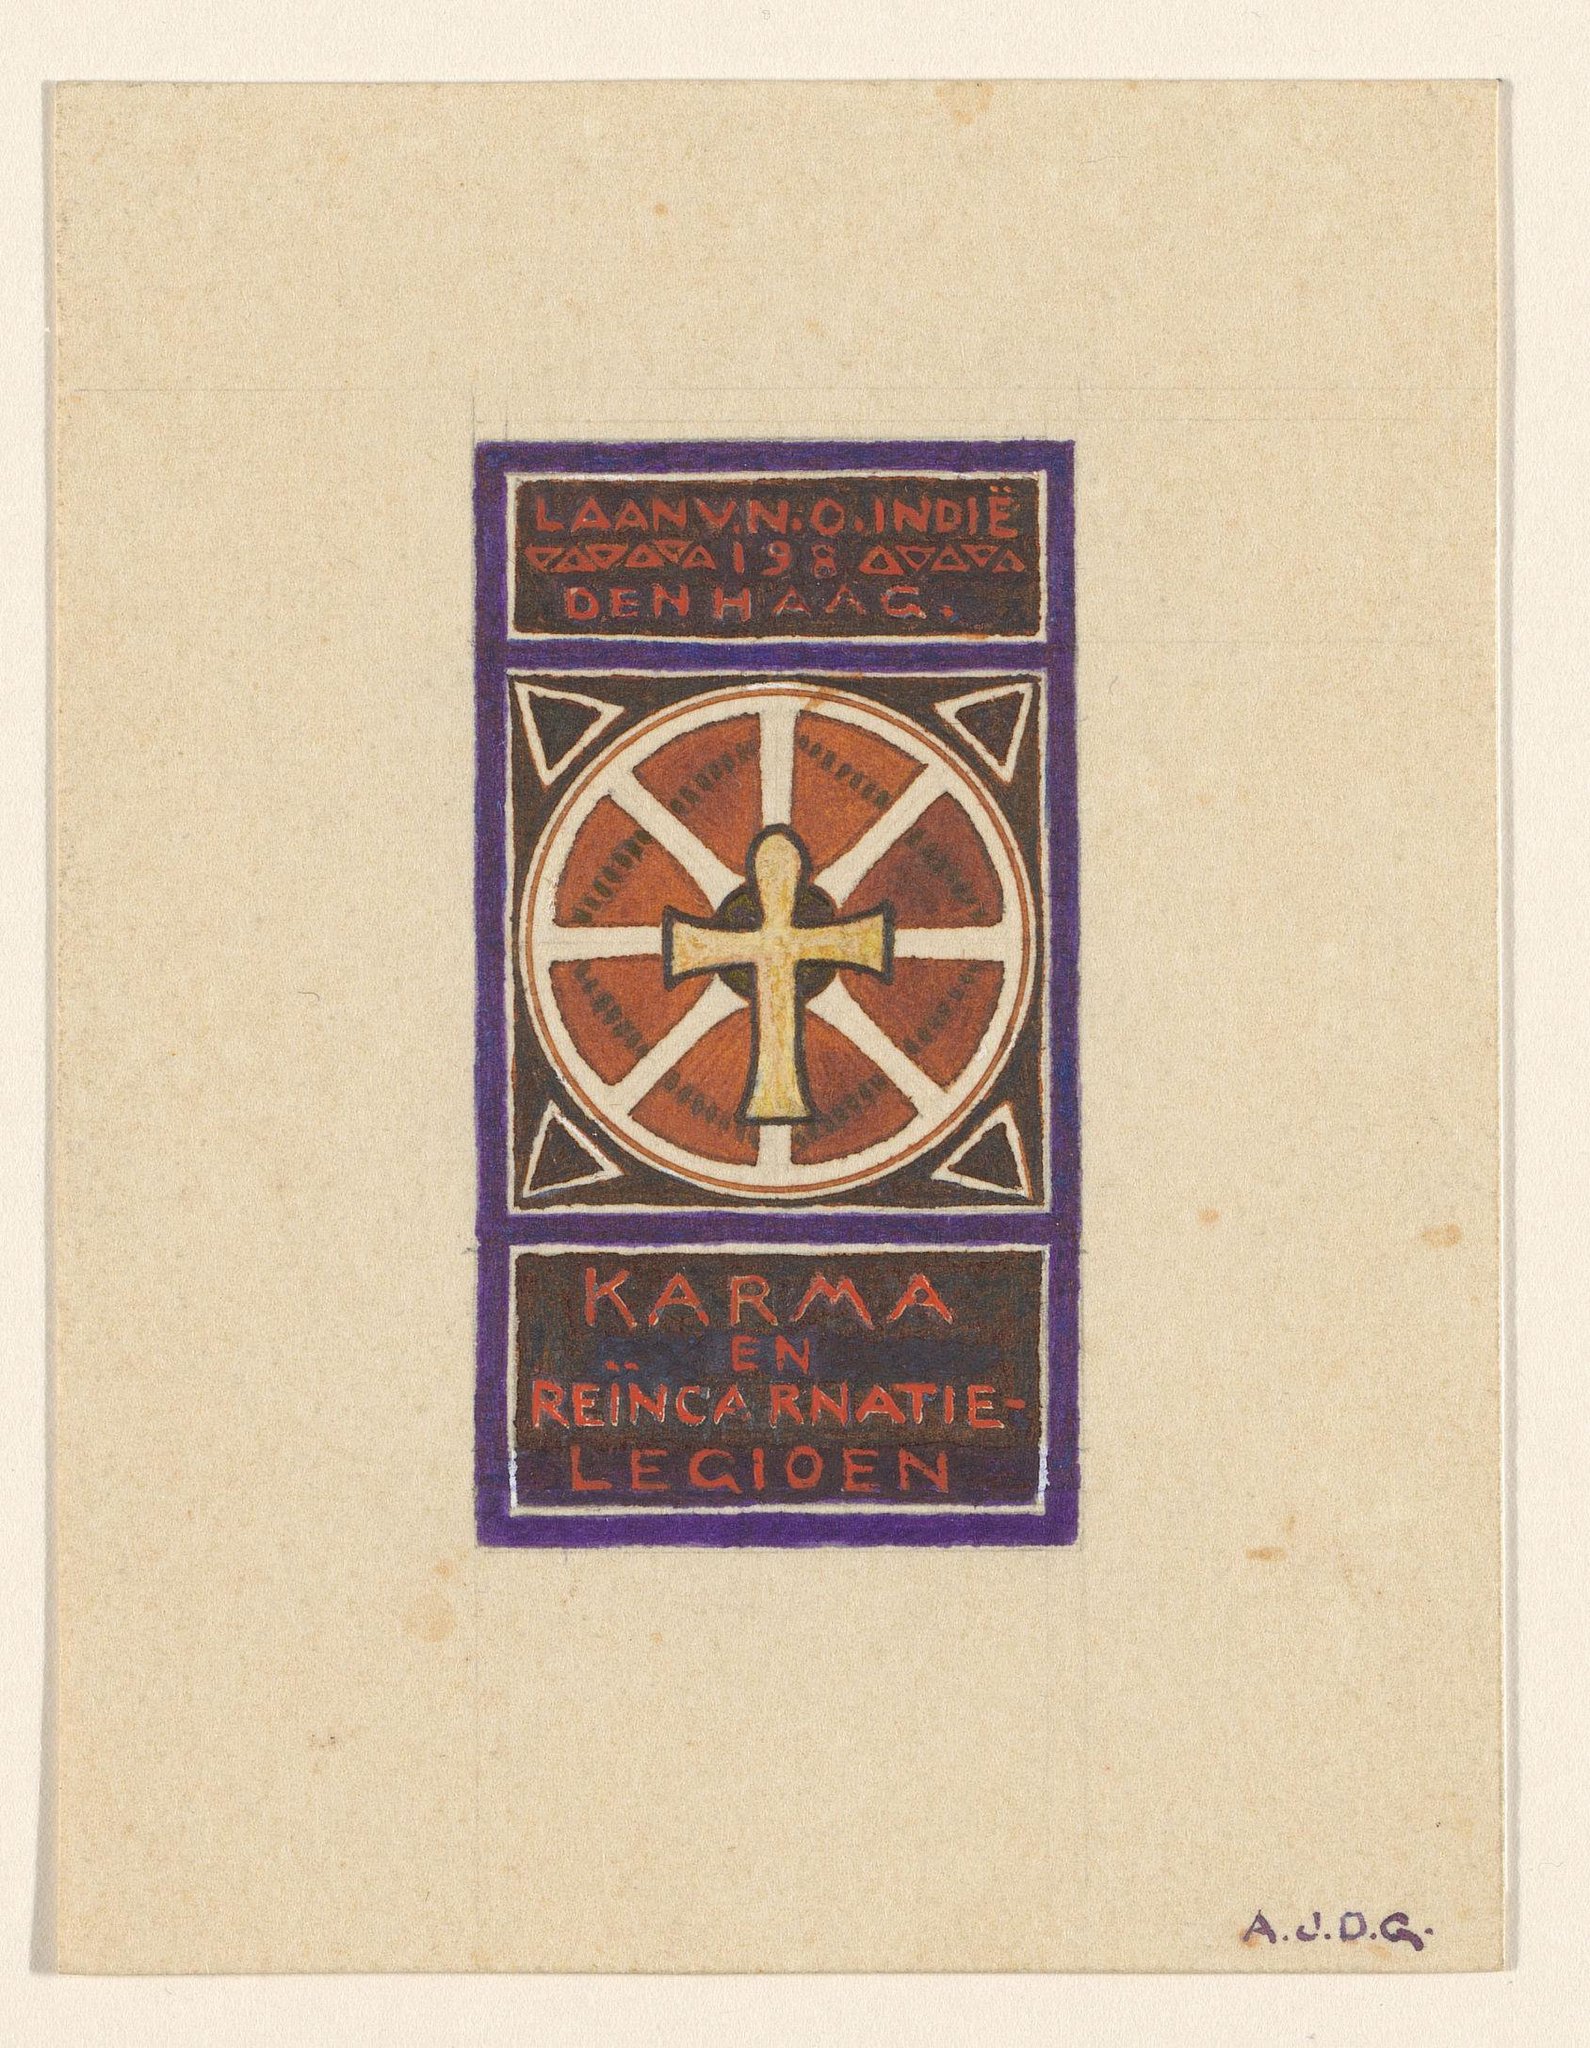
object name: drawing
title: Ontwerp voor een ex libris van het Karma en Reïncarnatie-Legioen te Den Haag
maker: julie de graag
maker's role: draughtsman, print maker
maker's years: 1877-1924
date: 1887-1924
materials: paint, ink, paper, pencil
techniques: brush, pen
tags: ornaments ~ art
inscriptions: number: ‘130 H’